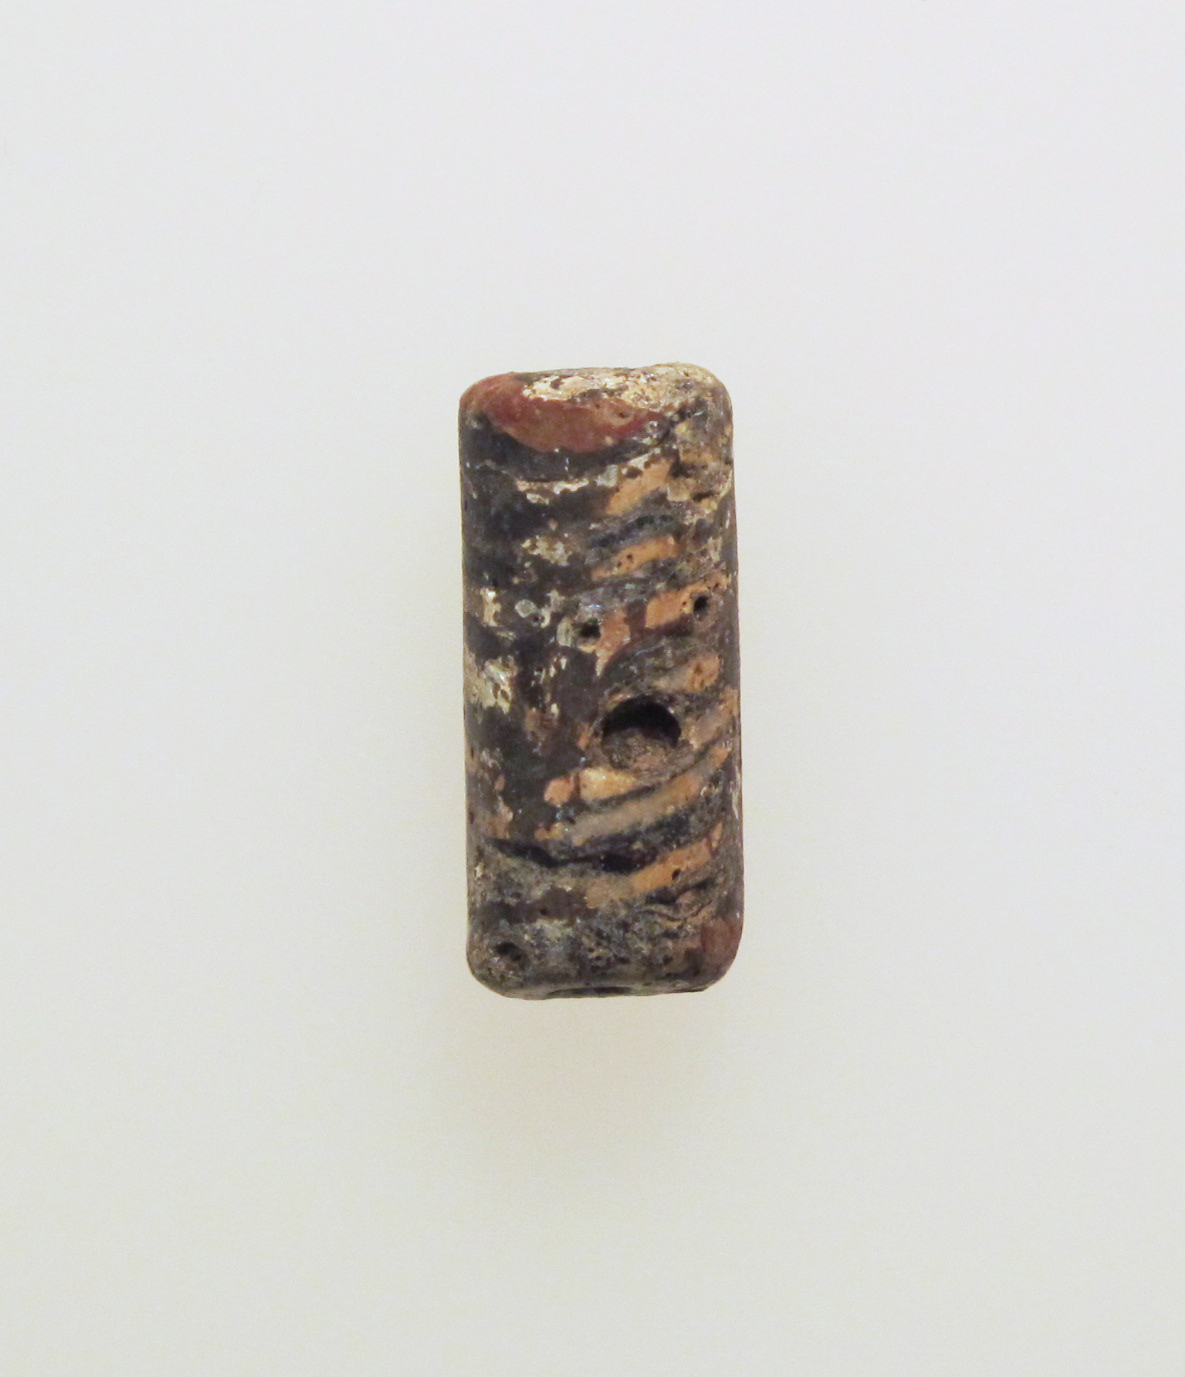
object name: bead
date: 7000 BCE-330 CE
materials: glass